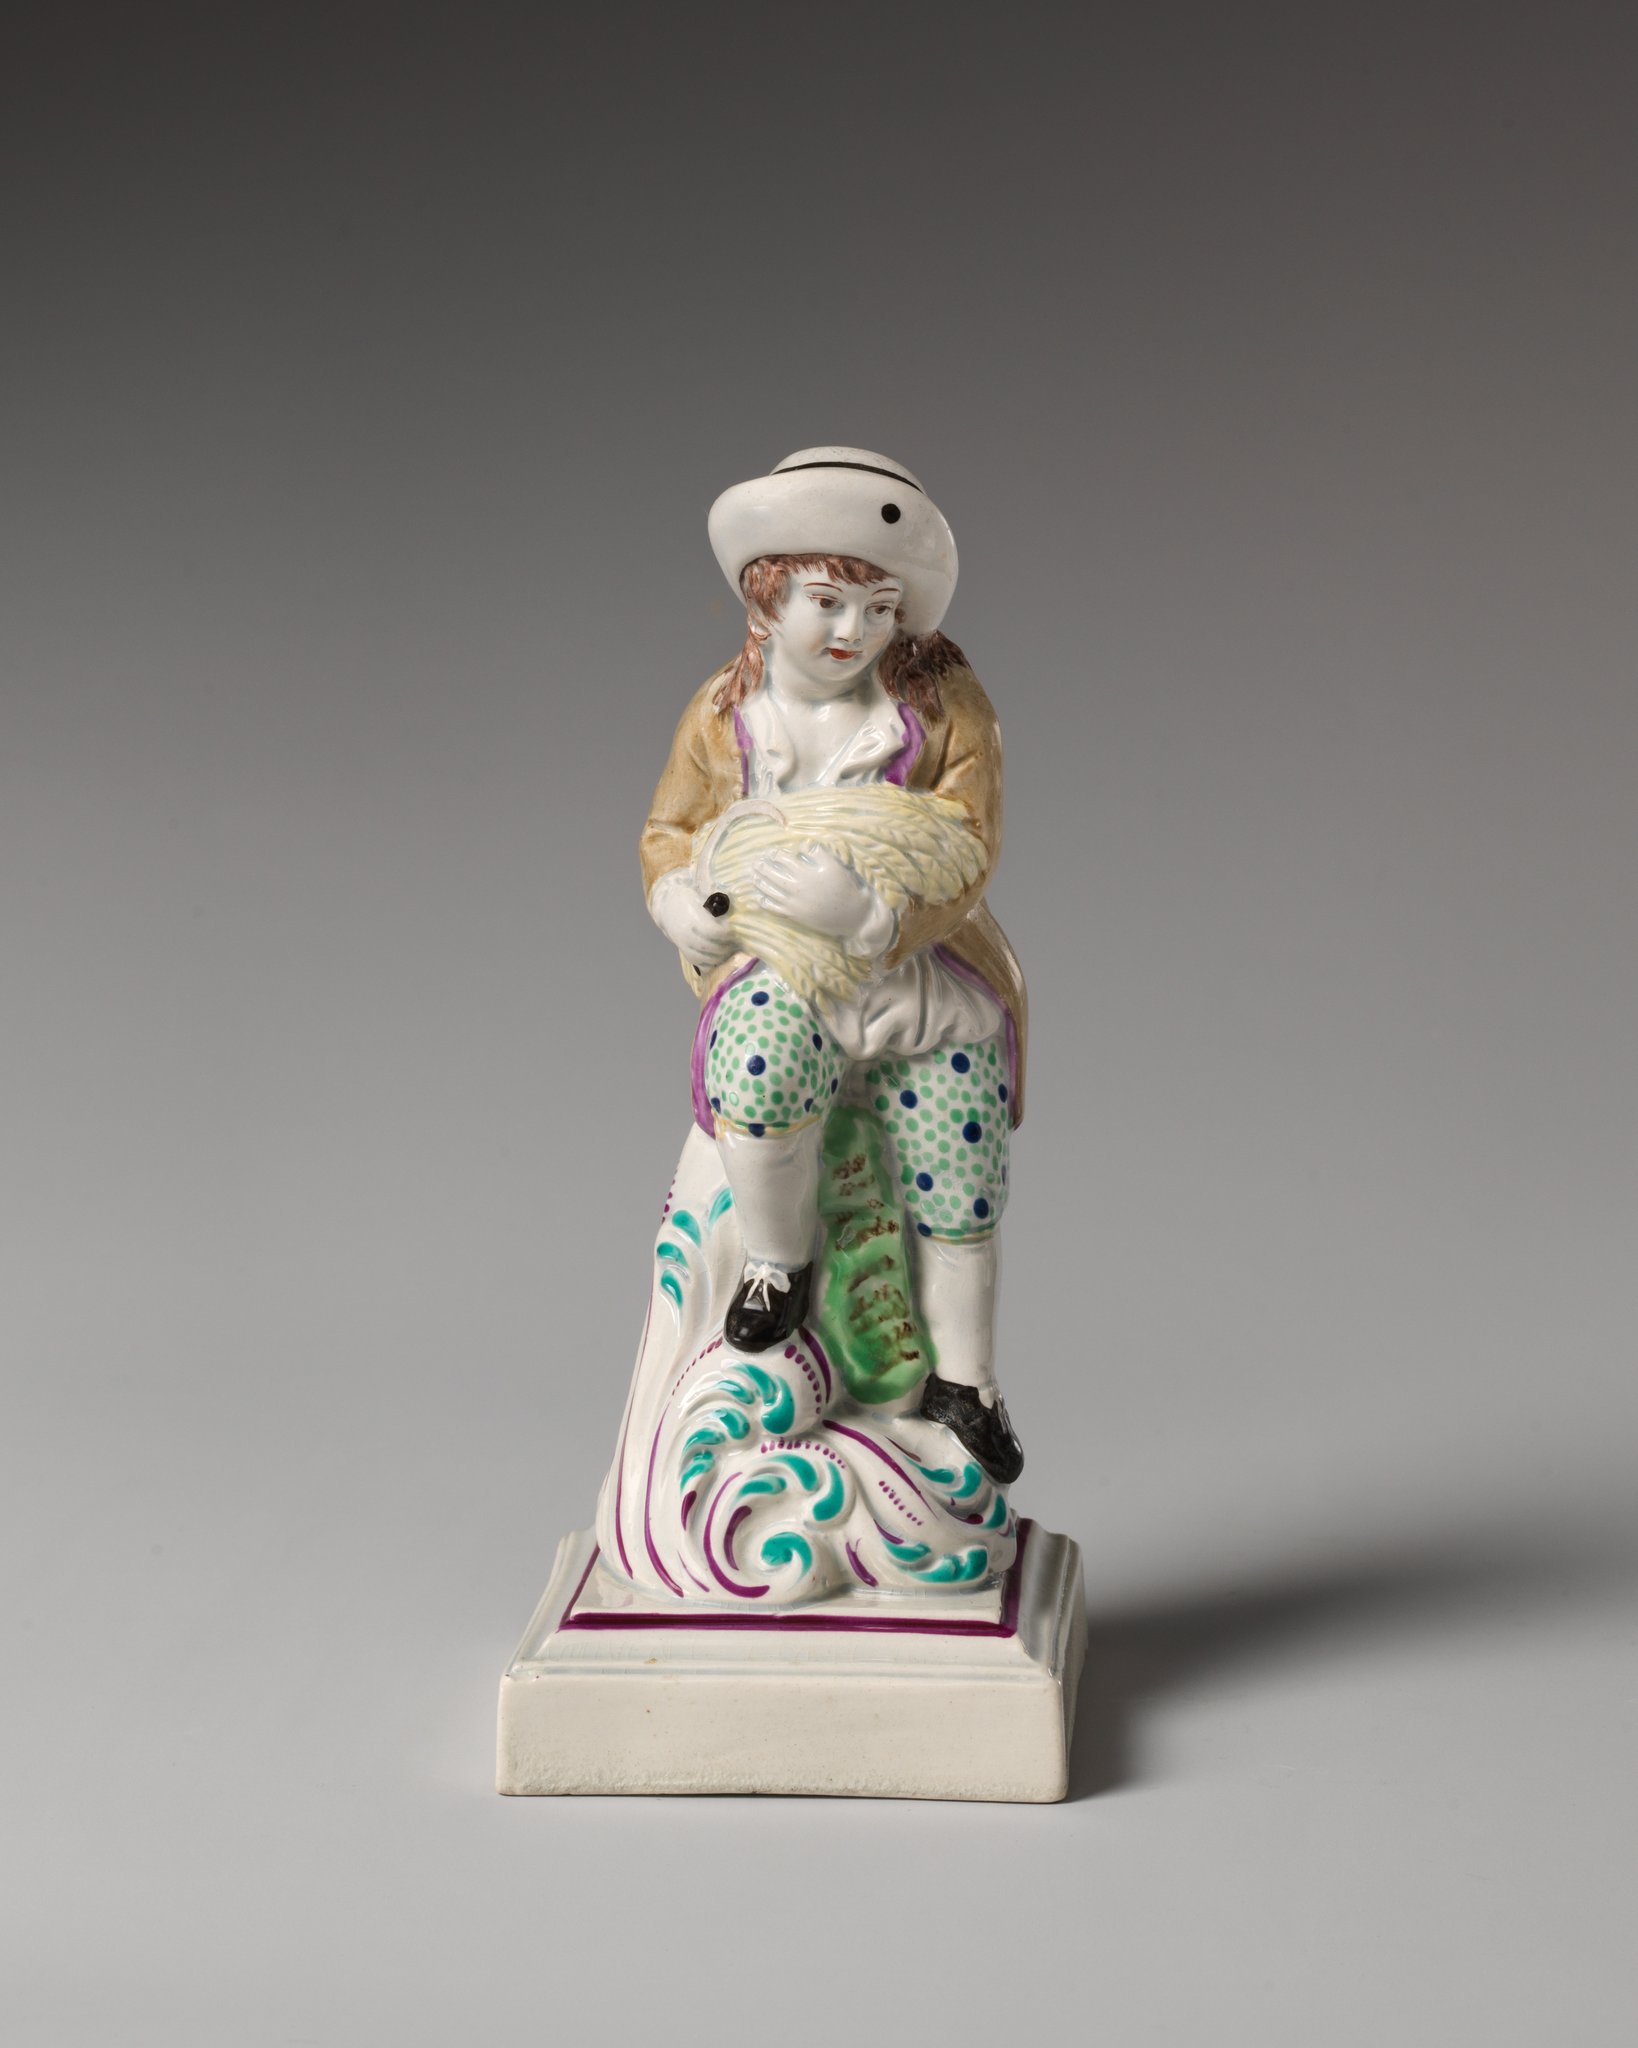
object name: figure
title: Summer (part of a set of four)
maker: neale & co.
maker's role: maker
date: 1780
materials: earthenware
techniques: enamel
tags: food,men,harvesting